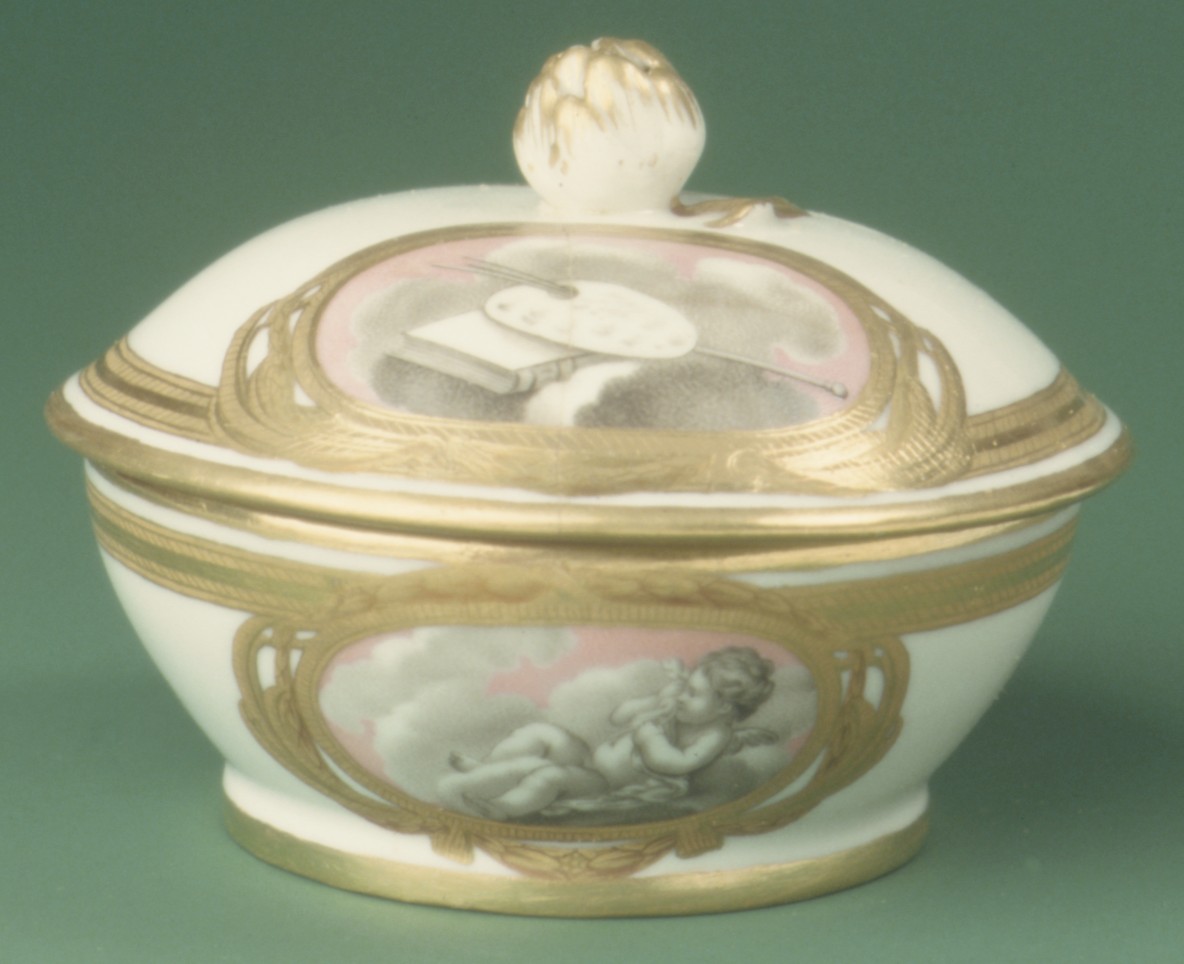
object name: sugar bowl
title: Sugar bowl (from a tea service)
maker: imperial porcelain manufactory, st. petersburg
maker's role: manufactory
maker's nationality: russian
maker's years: 1744-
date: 1775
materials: hard paste porcelain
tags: putti